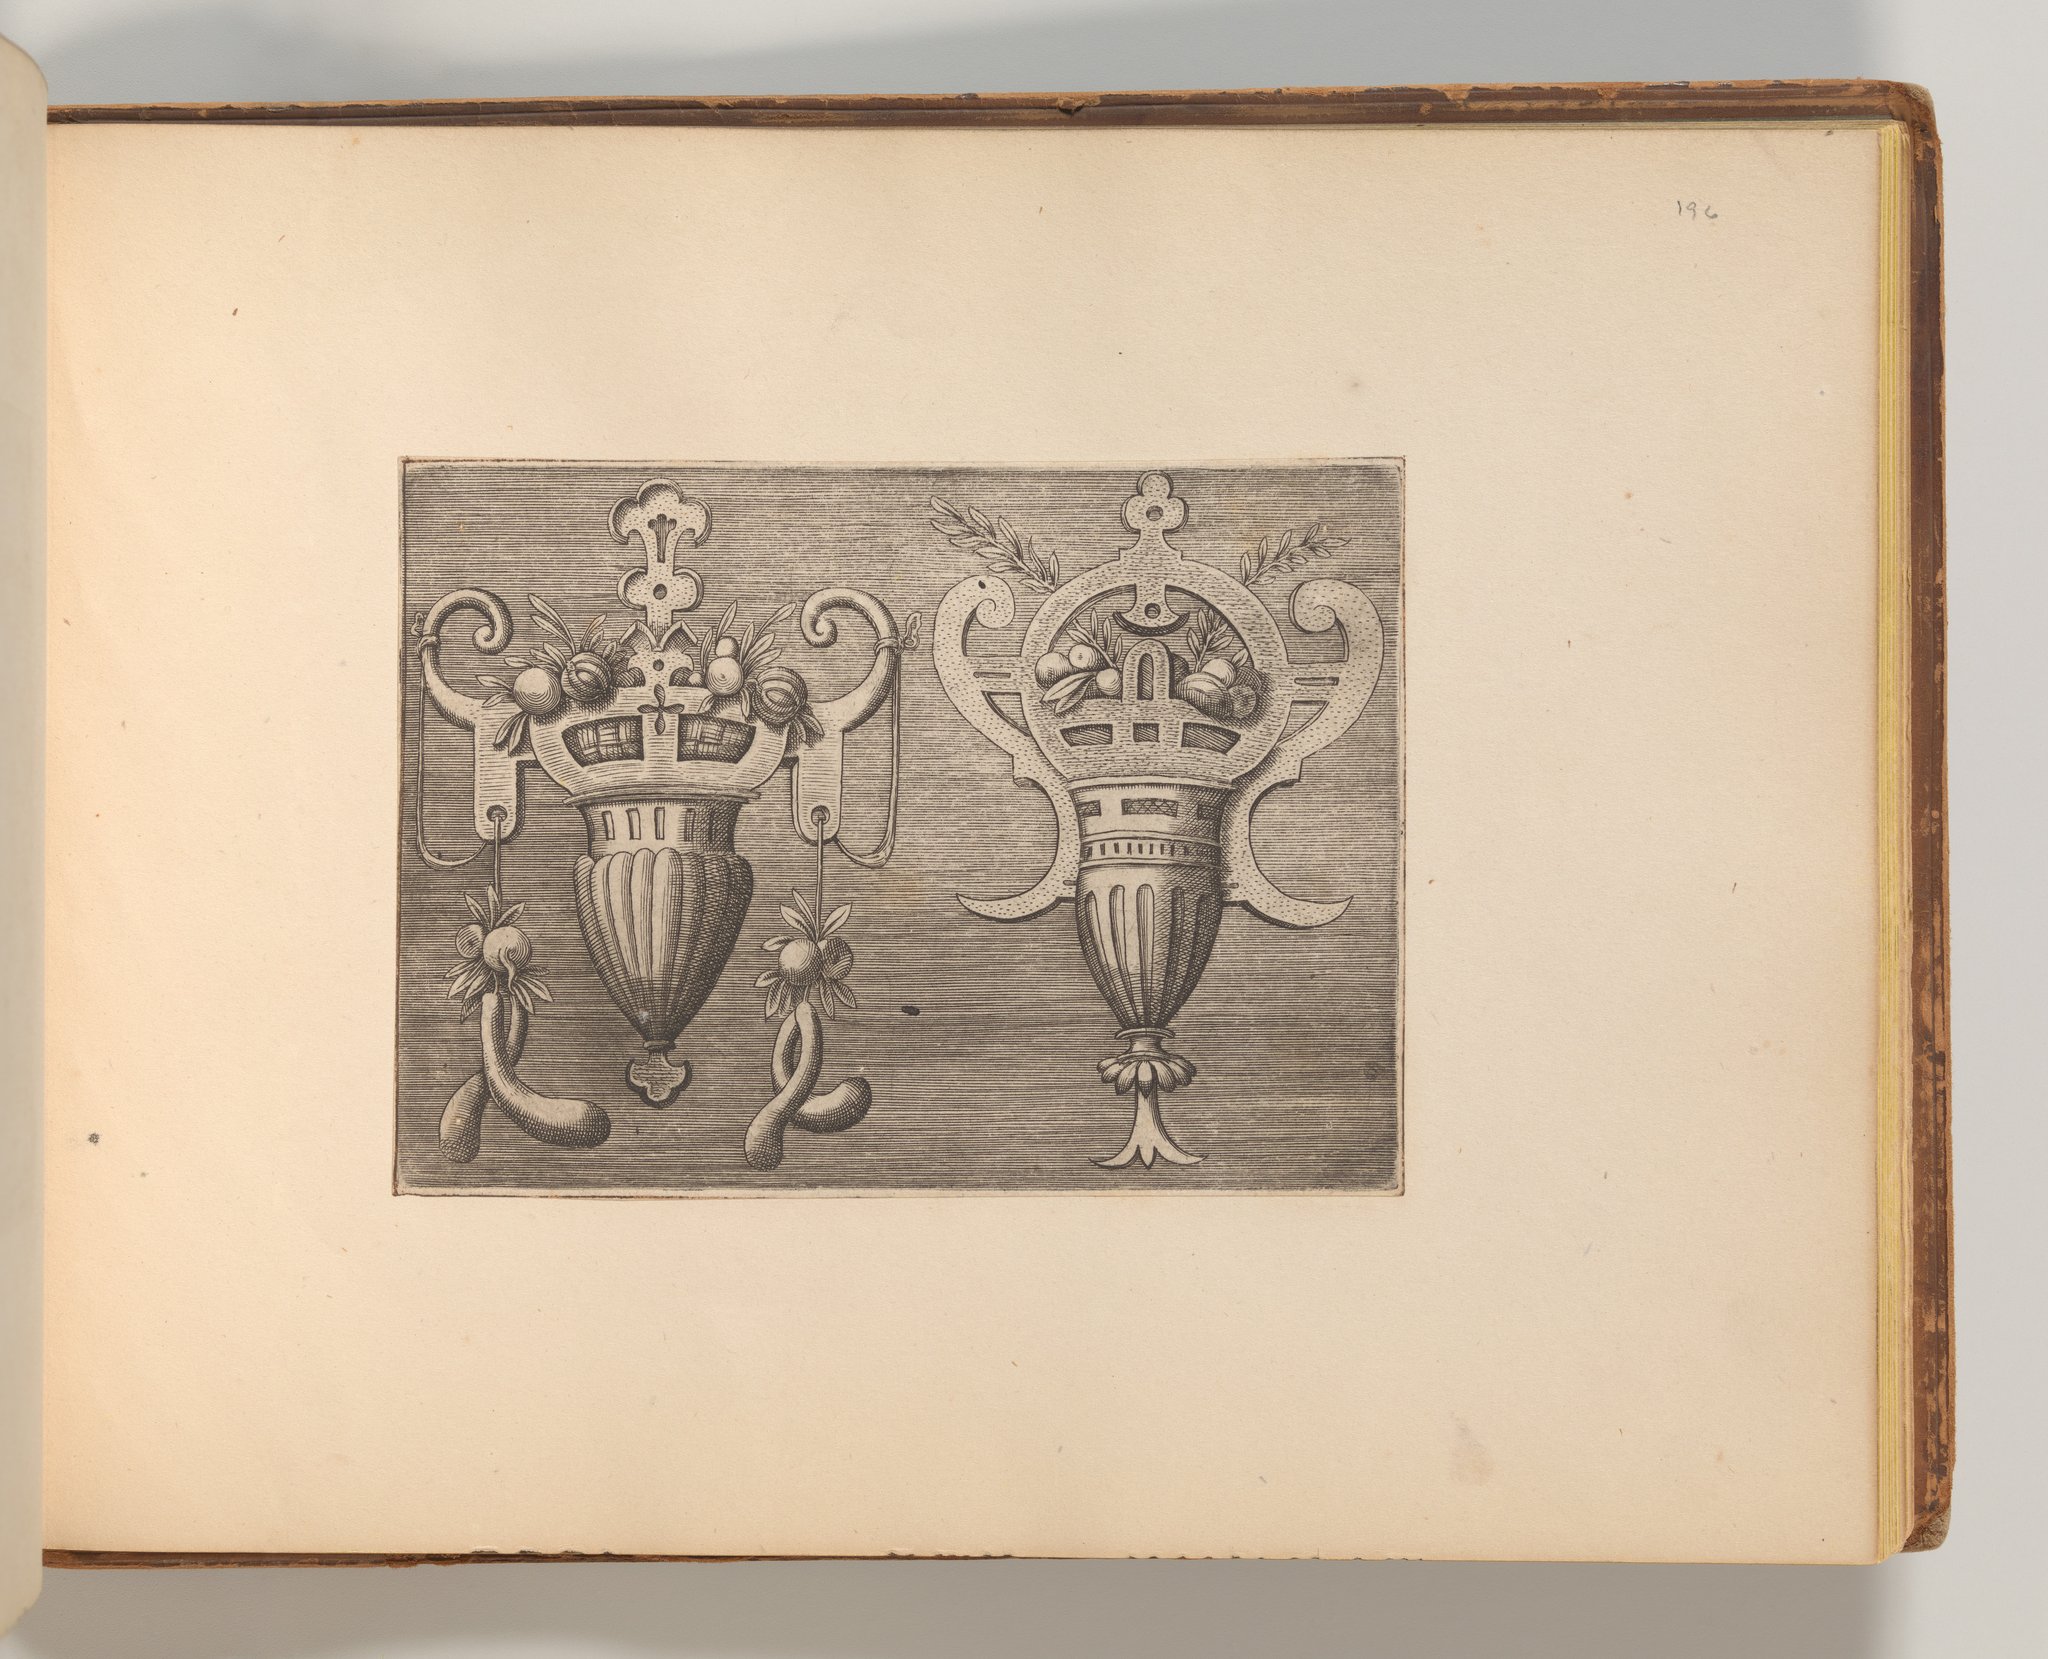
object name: album print ornament architecture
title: Series of Cartouches, in: Targhe ed altri ornati di varie e capricciose invenzioni (Cartouches and other ornaments of various and capricious invention, page 44)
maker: cornelis bos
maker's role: artist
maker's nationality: netherlandish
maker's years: 1510-1556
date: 1545-1560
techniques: engraving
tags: cartouches,ornament